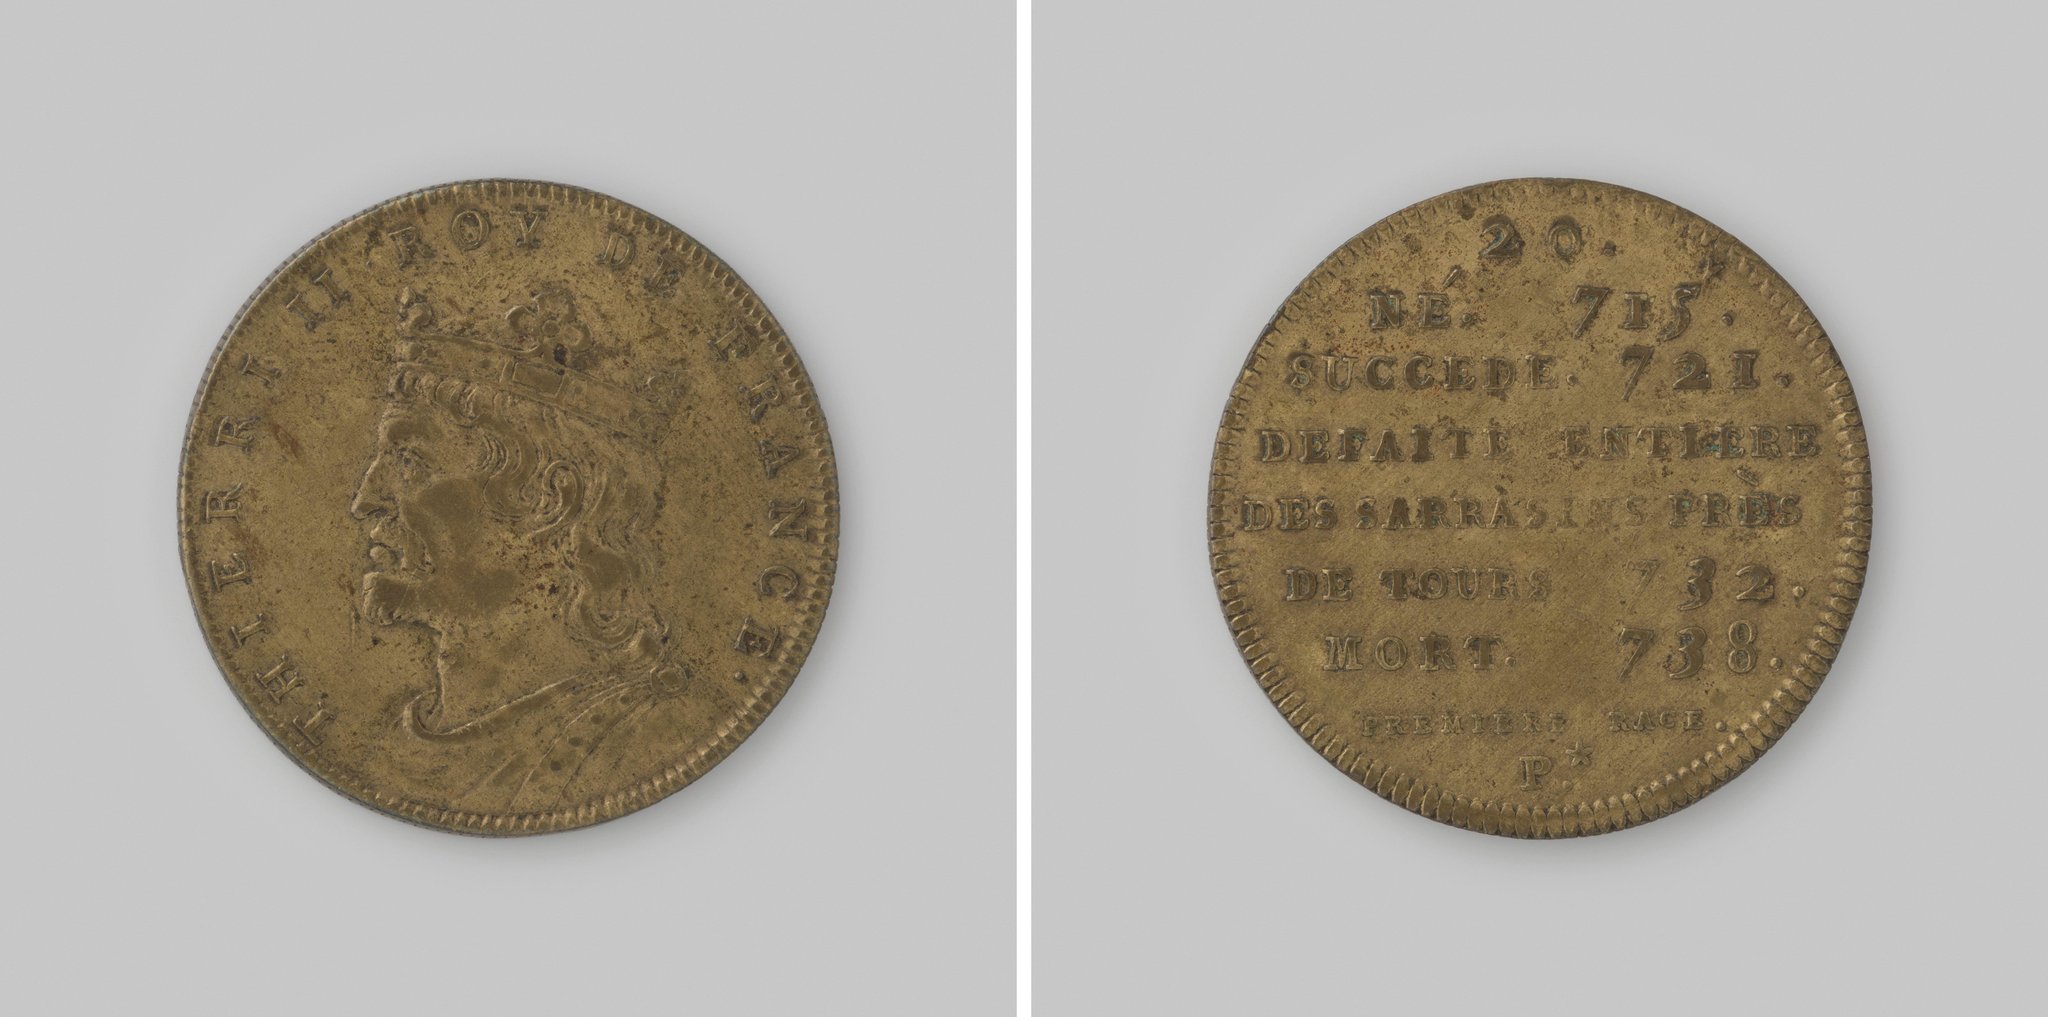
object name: history medal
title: Franse koningen van het eerste ras - Diederik I (721-738)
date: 1800-1900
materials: brass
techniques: striking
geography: france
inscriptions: inscription: ‘20. / NÉ. 715.* / SUCCEDE. 721. / DEFAITE ENTIERE / DES SARRASINS PRÈS / DE TOURS. 732. / MORT. 738. / PREMIERE RACE.’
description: Messing penning, op de voorzijde het portret van Diederik II naar links met omschrift, op de keerzijde negenregelige tekst, kartelrand.